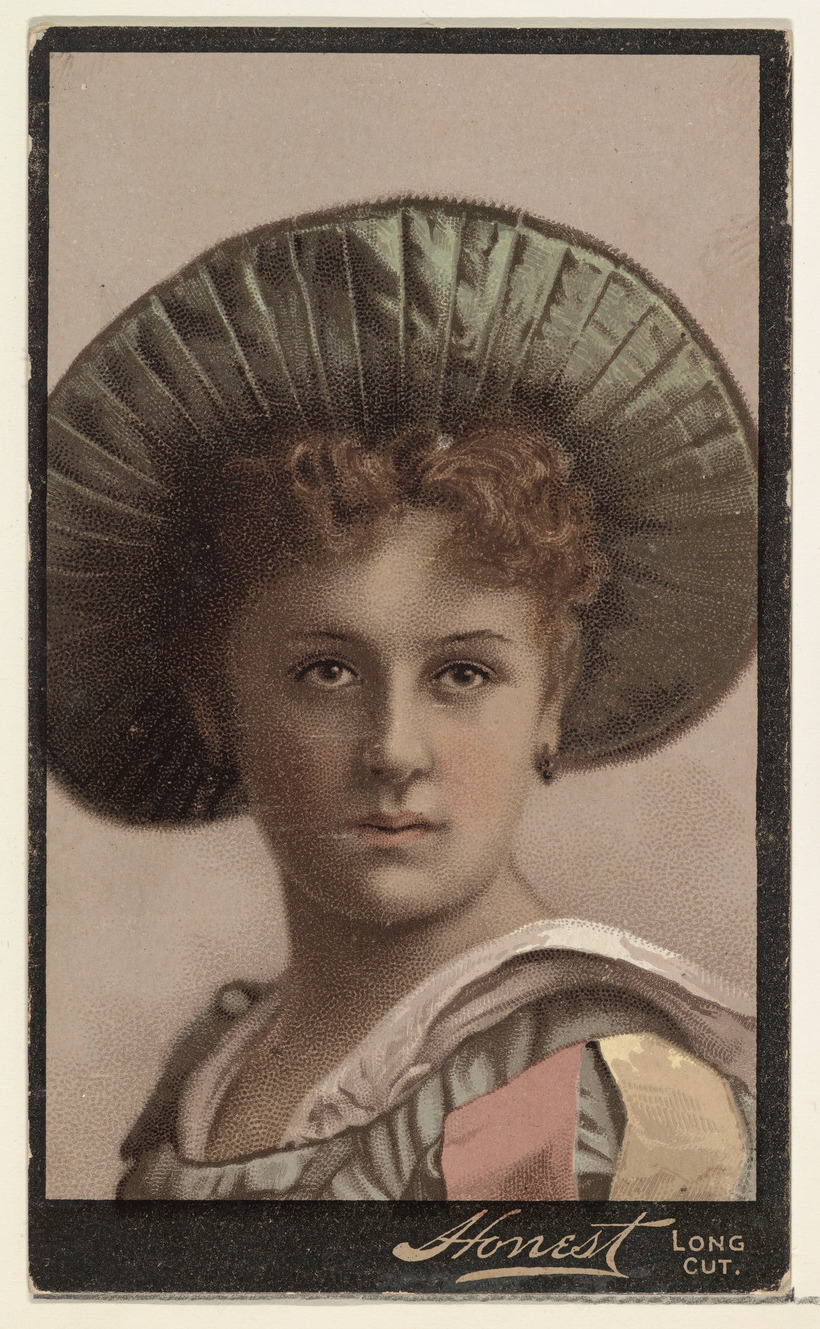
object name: print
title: Actress wearing wide-brimmed hat lined with green folded fabric, from Stars of the Stage, Third Series (N131) issued by Duke Sons & Co. to promote Honest Long Cut Tobacco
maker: w. duke, sons & co.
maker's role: publisher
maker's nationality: american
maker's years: 1870-1920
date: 1891-1892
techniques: color lithograph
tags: hats,portraits,women,actresses